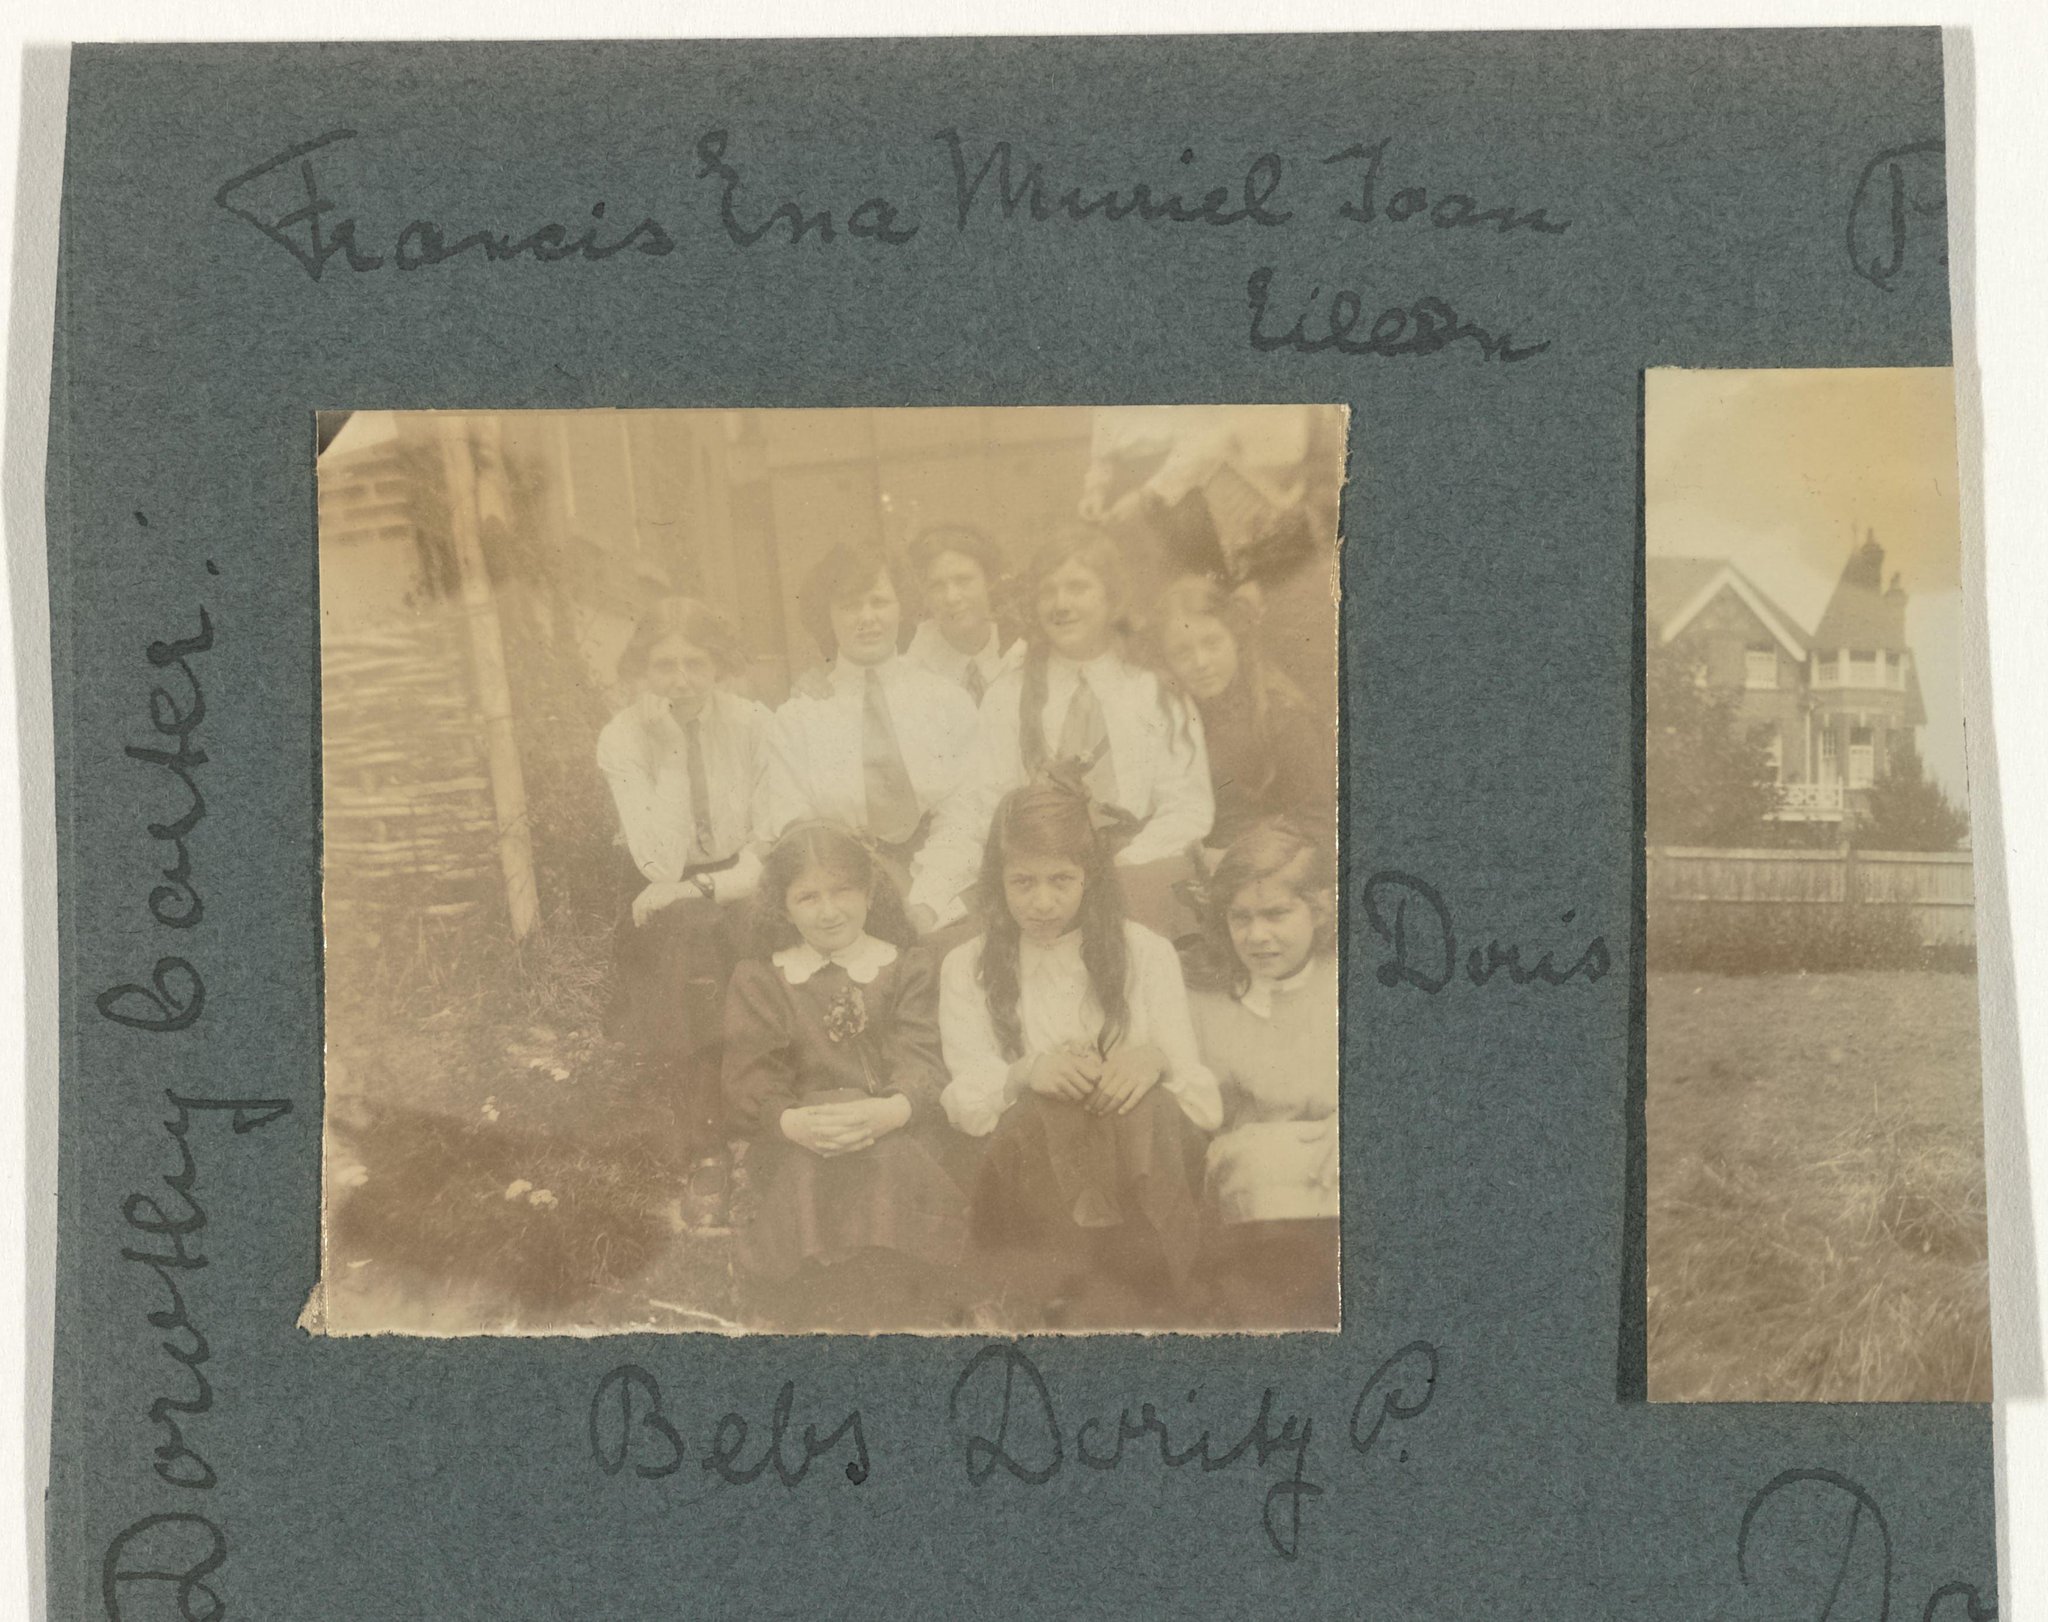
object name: photograph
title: Francis, Ena, Muriel, Joan, Eilee, Doris, Bebs en Dority achtergrond in Bexhill-on-Sea in Engeland, 1913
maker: Anonymous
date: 1913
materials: photographic support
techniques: gelatin silver print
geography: bexhill-on-sea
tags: england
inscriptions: inscription: ‘Francis Ena Muriel Joan Eileen Doris Bebs Dority’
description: Francis (achter, 1e van links), Ena (achter, 2e van links), Muriel (achter, midden), Joan (achter, 2e van rechts), Eileen (achter, 1e van rechts), Doris (voor, links), Bebs (voor, midden) en Dority (voor, rechts) achtergrond in Bexhill-on-Sea in Engeland.